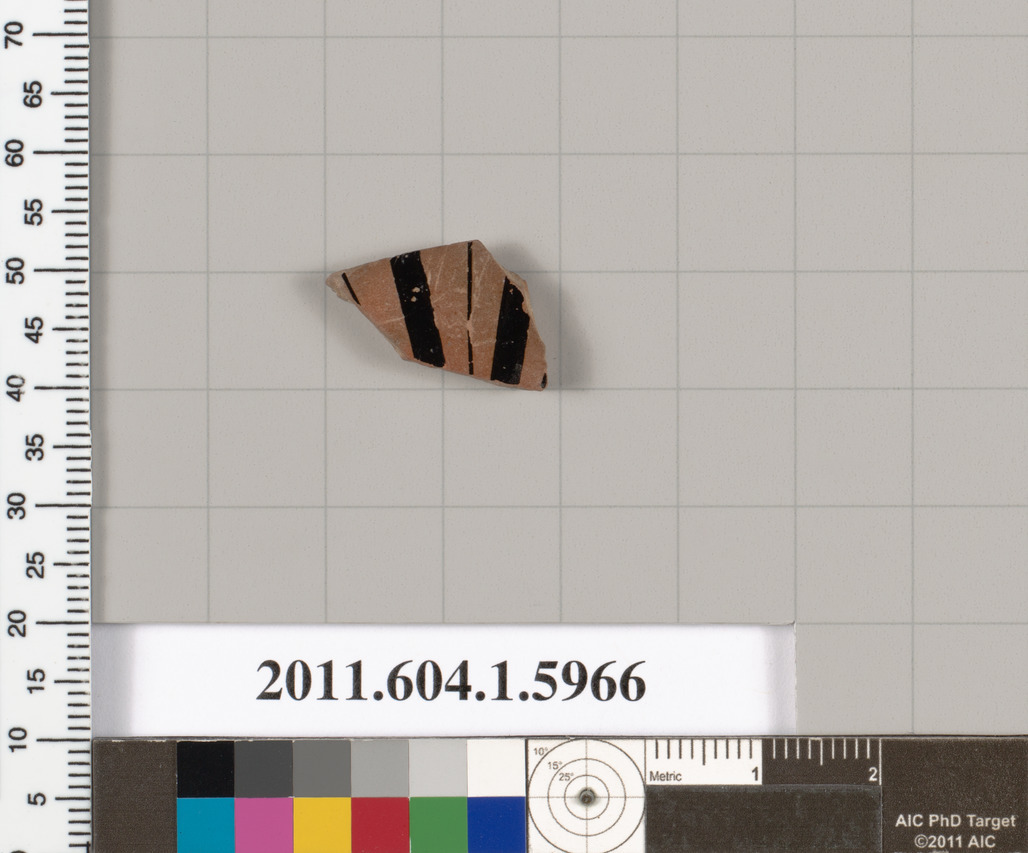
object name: kylix fragment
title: Terracotta fragment of a kylix (drinking cup)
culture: greek, attic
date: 433-567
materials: terracotta